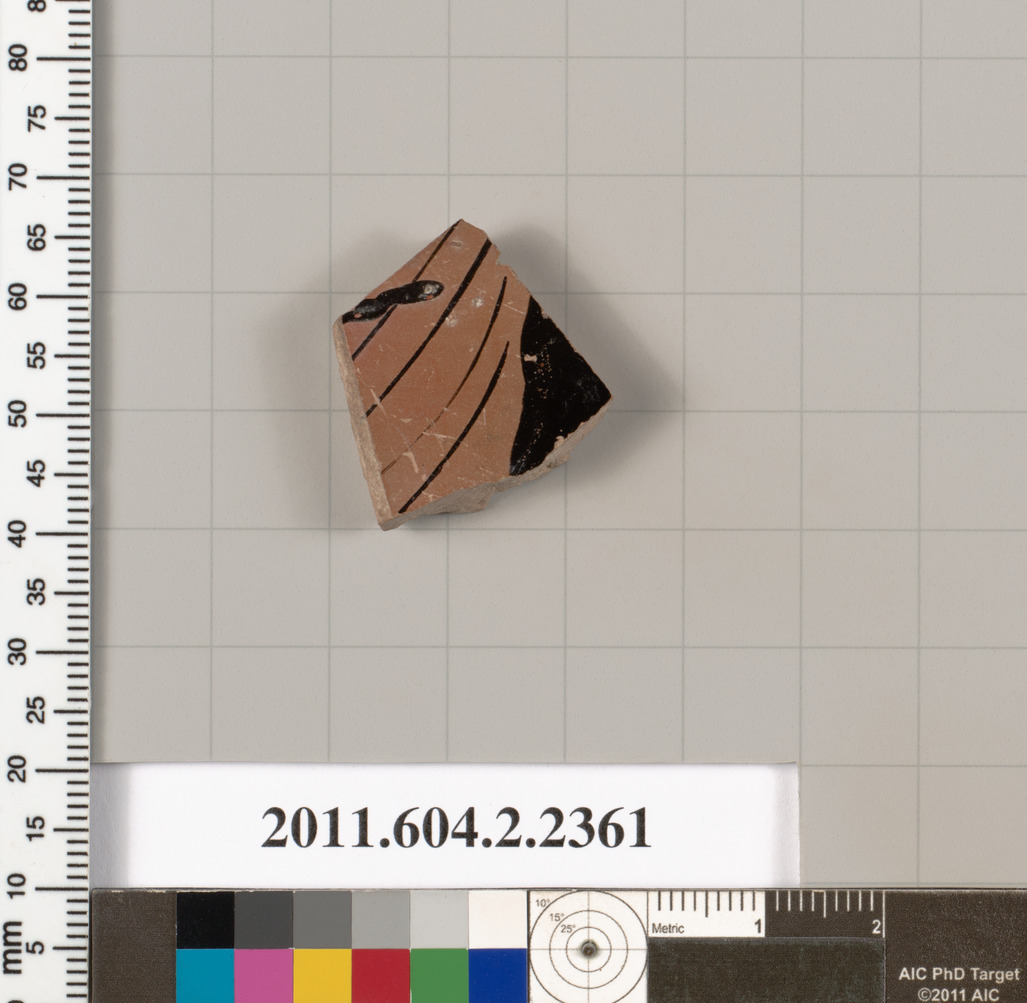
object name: pot fragment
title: Terracotta fragment of a pot; unglazed on the inside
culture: greek, attic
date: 475-451 BCE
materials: terracotta